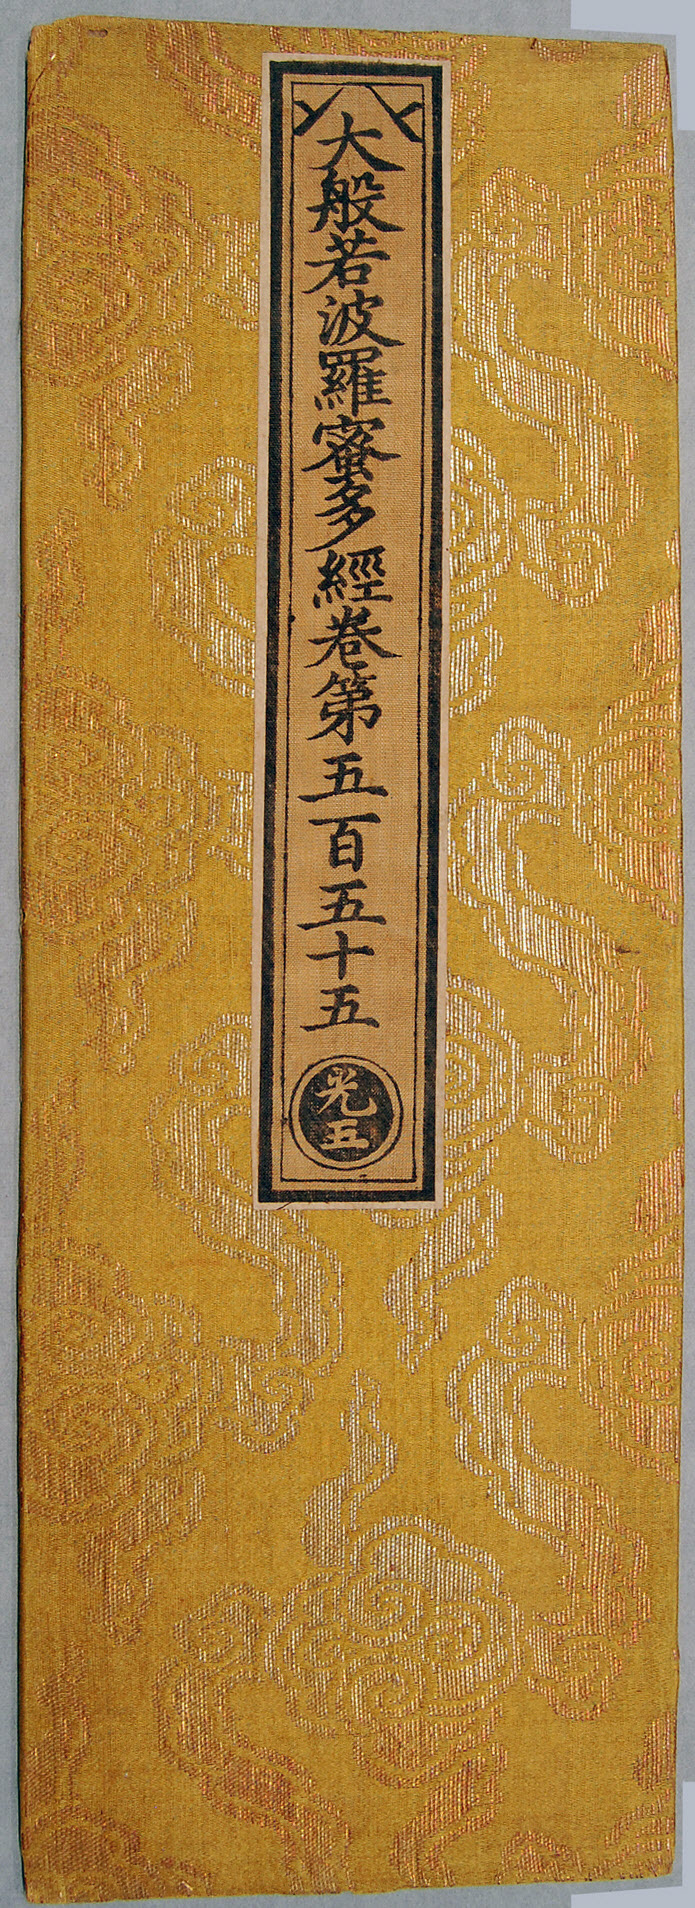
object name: sutra cover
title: Sutra Cover with Pattern of Diagonal Bands of Clouds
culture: chinese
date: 1501-1600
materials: metal thread, silk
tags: clouds